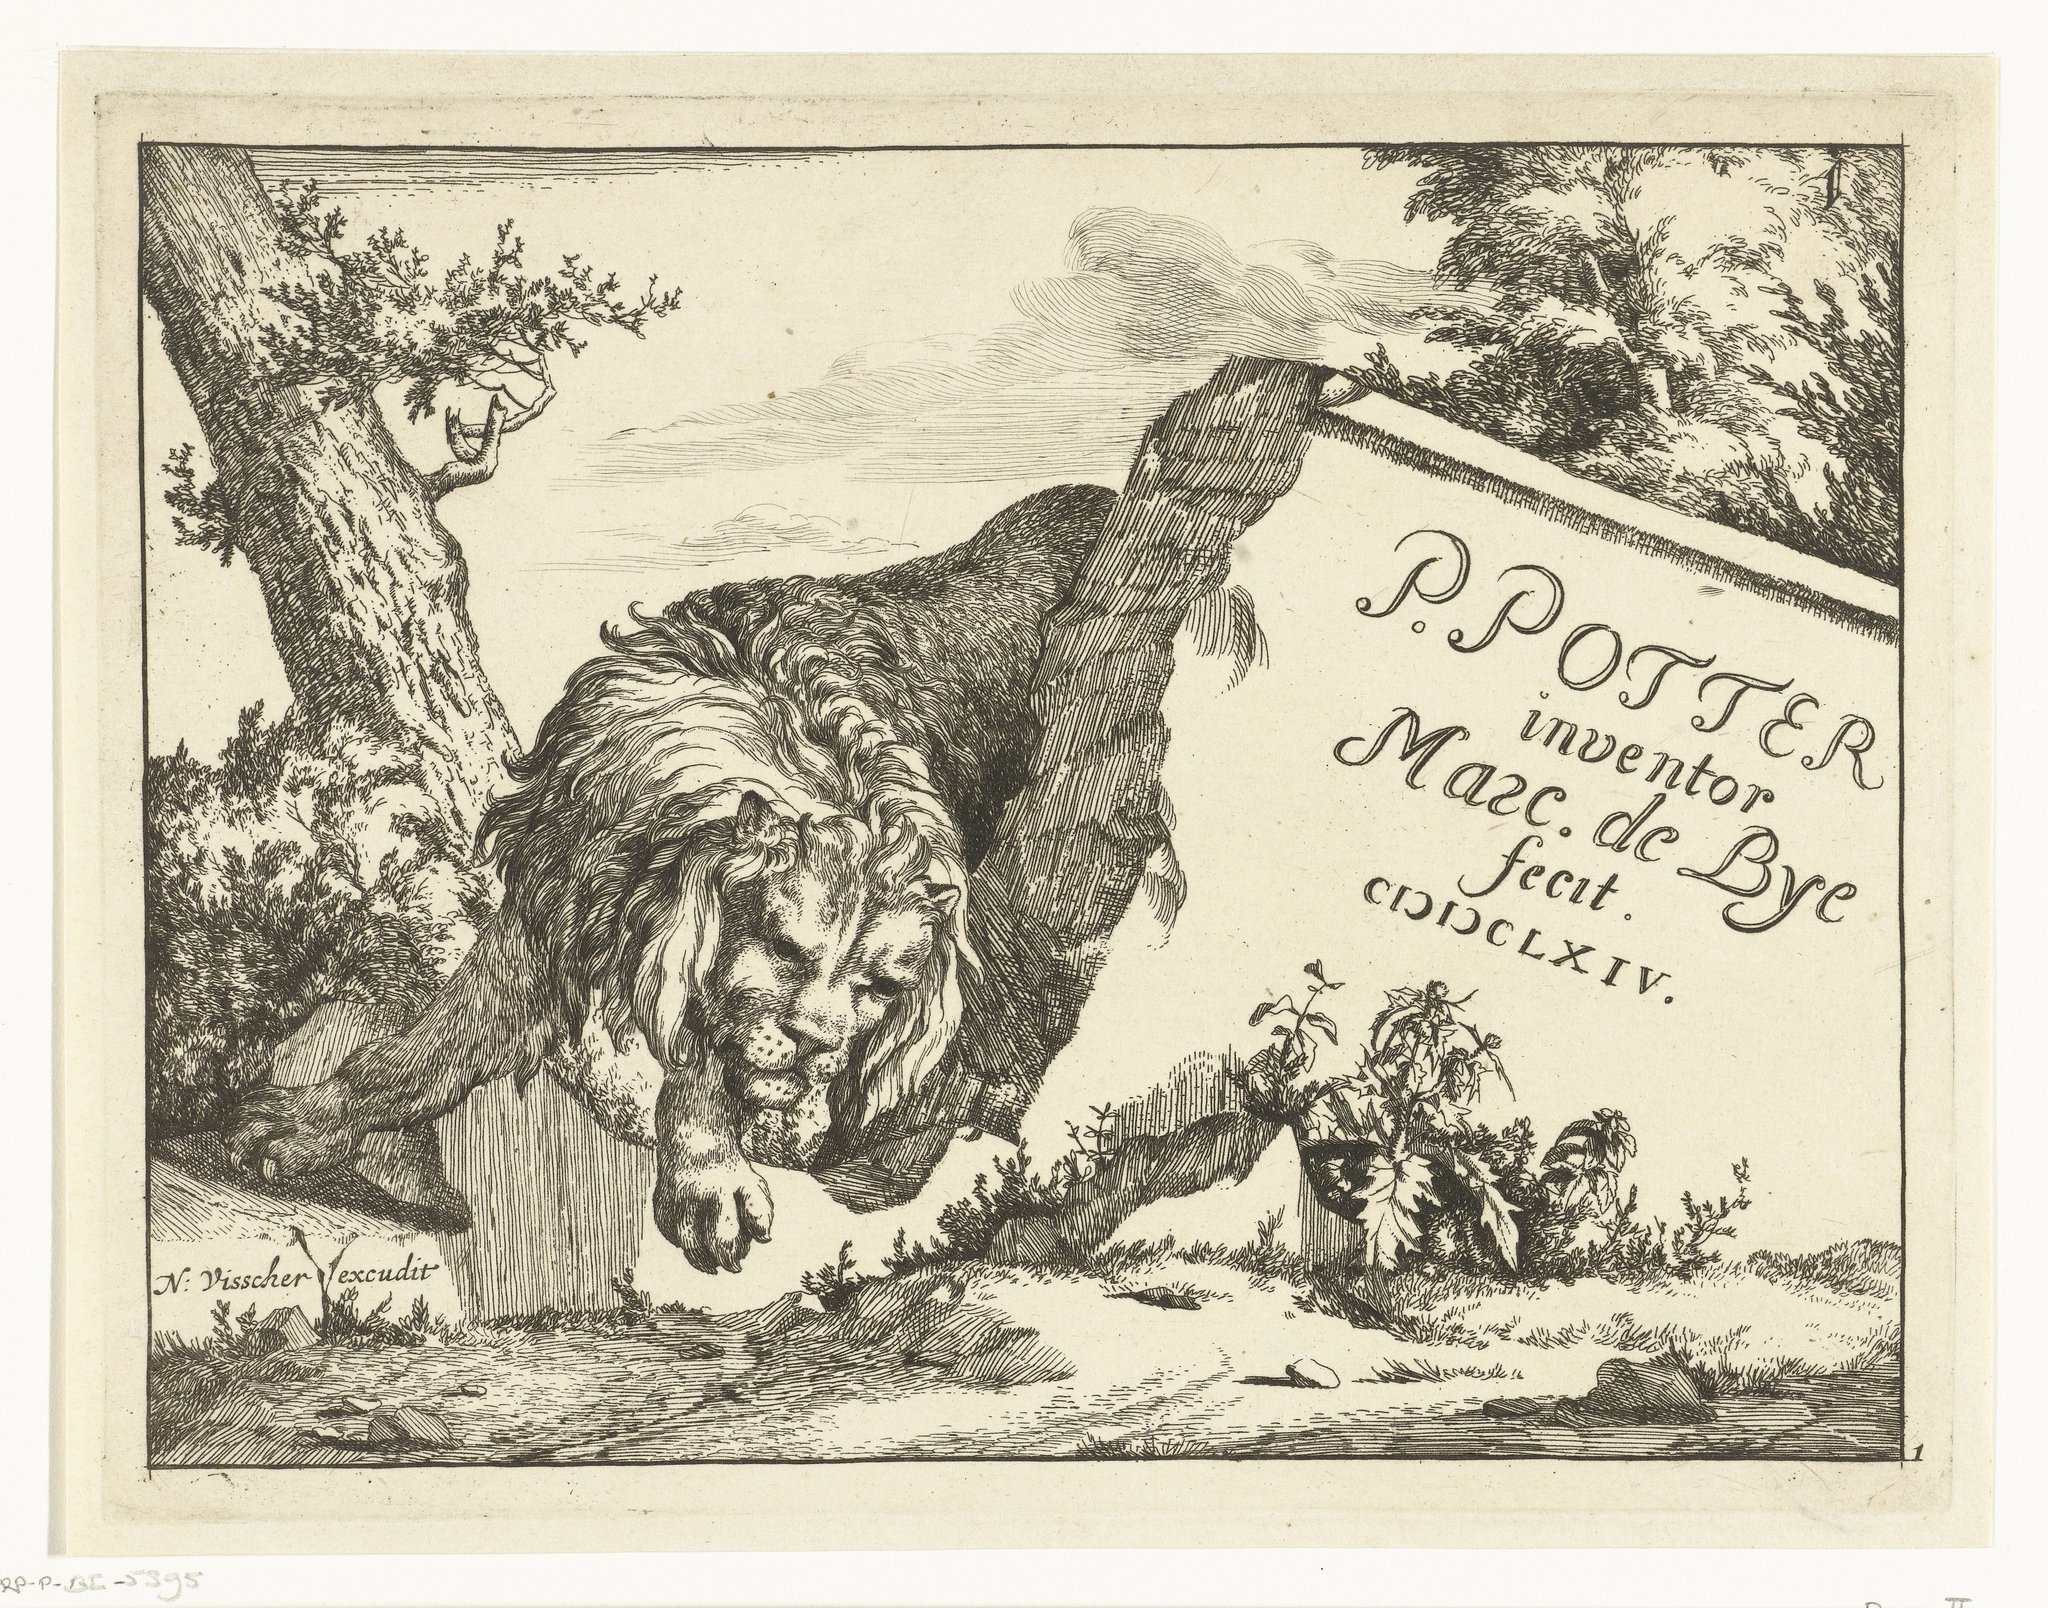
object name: print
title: Leeuwen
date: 1664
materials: paper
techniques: etching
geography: the hague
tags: beasts of prey, predatory animals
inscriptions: collector's mark: Lugt 240